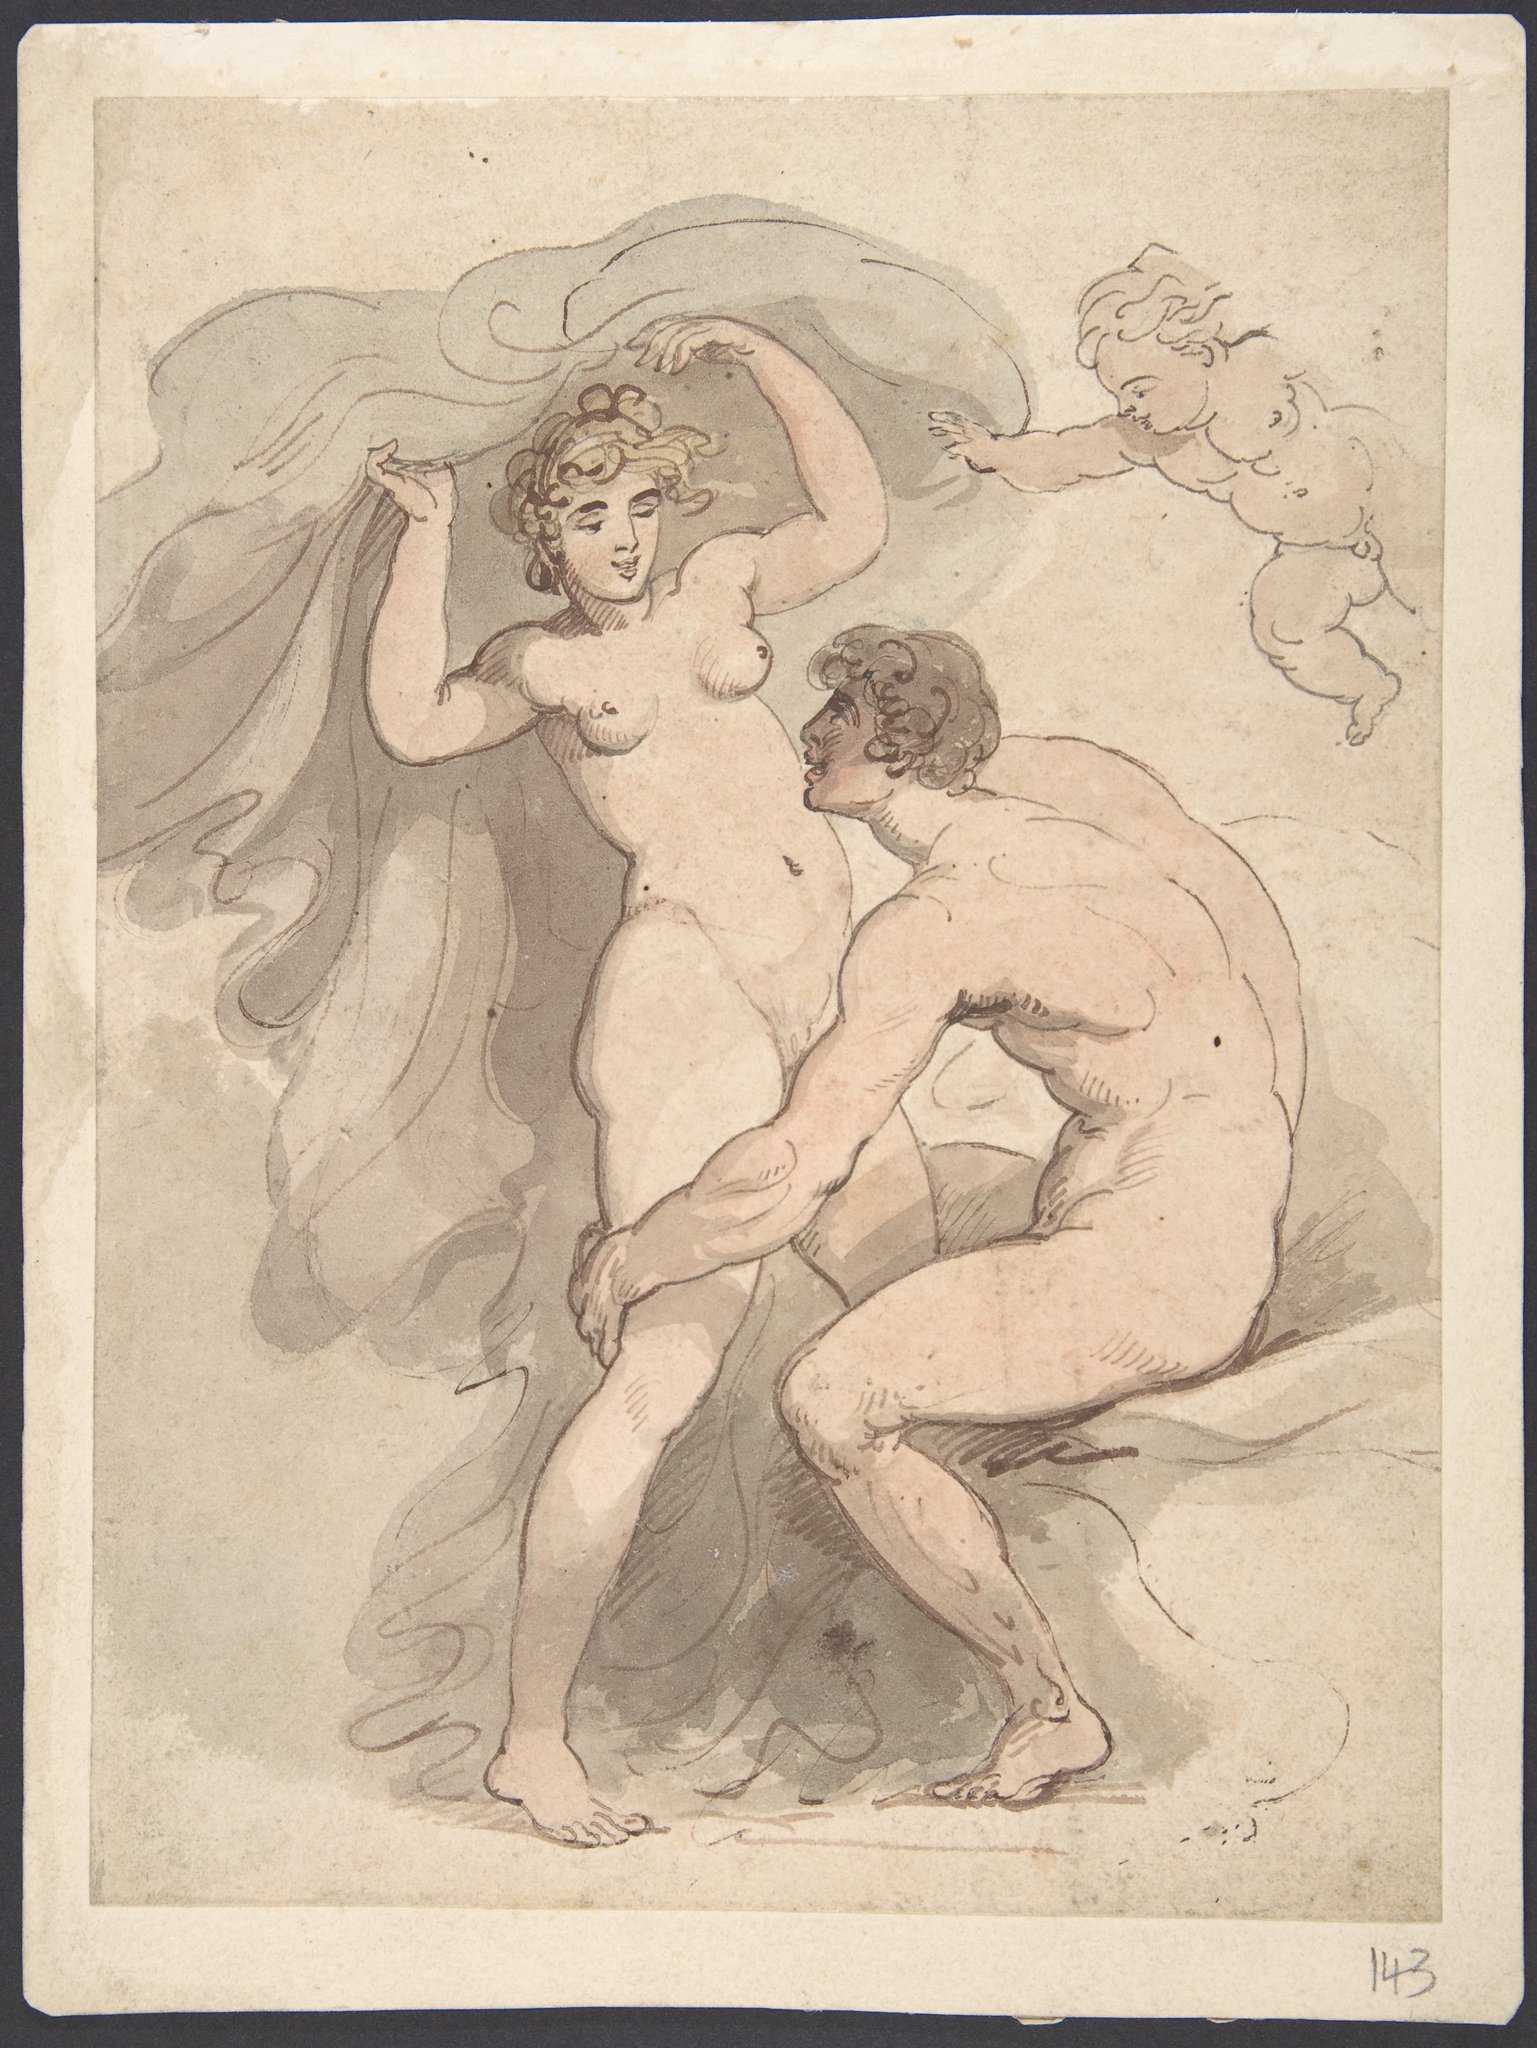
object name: drawing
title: Venus, Anchises and Cupid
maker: thomas rowlandson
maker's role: artist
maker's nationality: british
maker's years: 1757-1827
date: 1780-1827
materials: watercolor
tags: male nudes,female nudes,cupid,venus